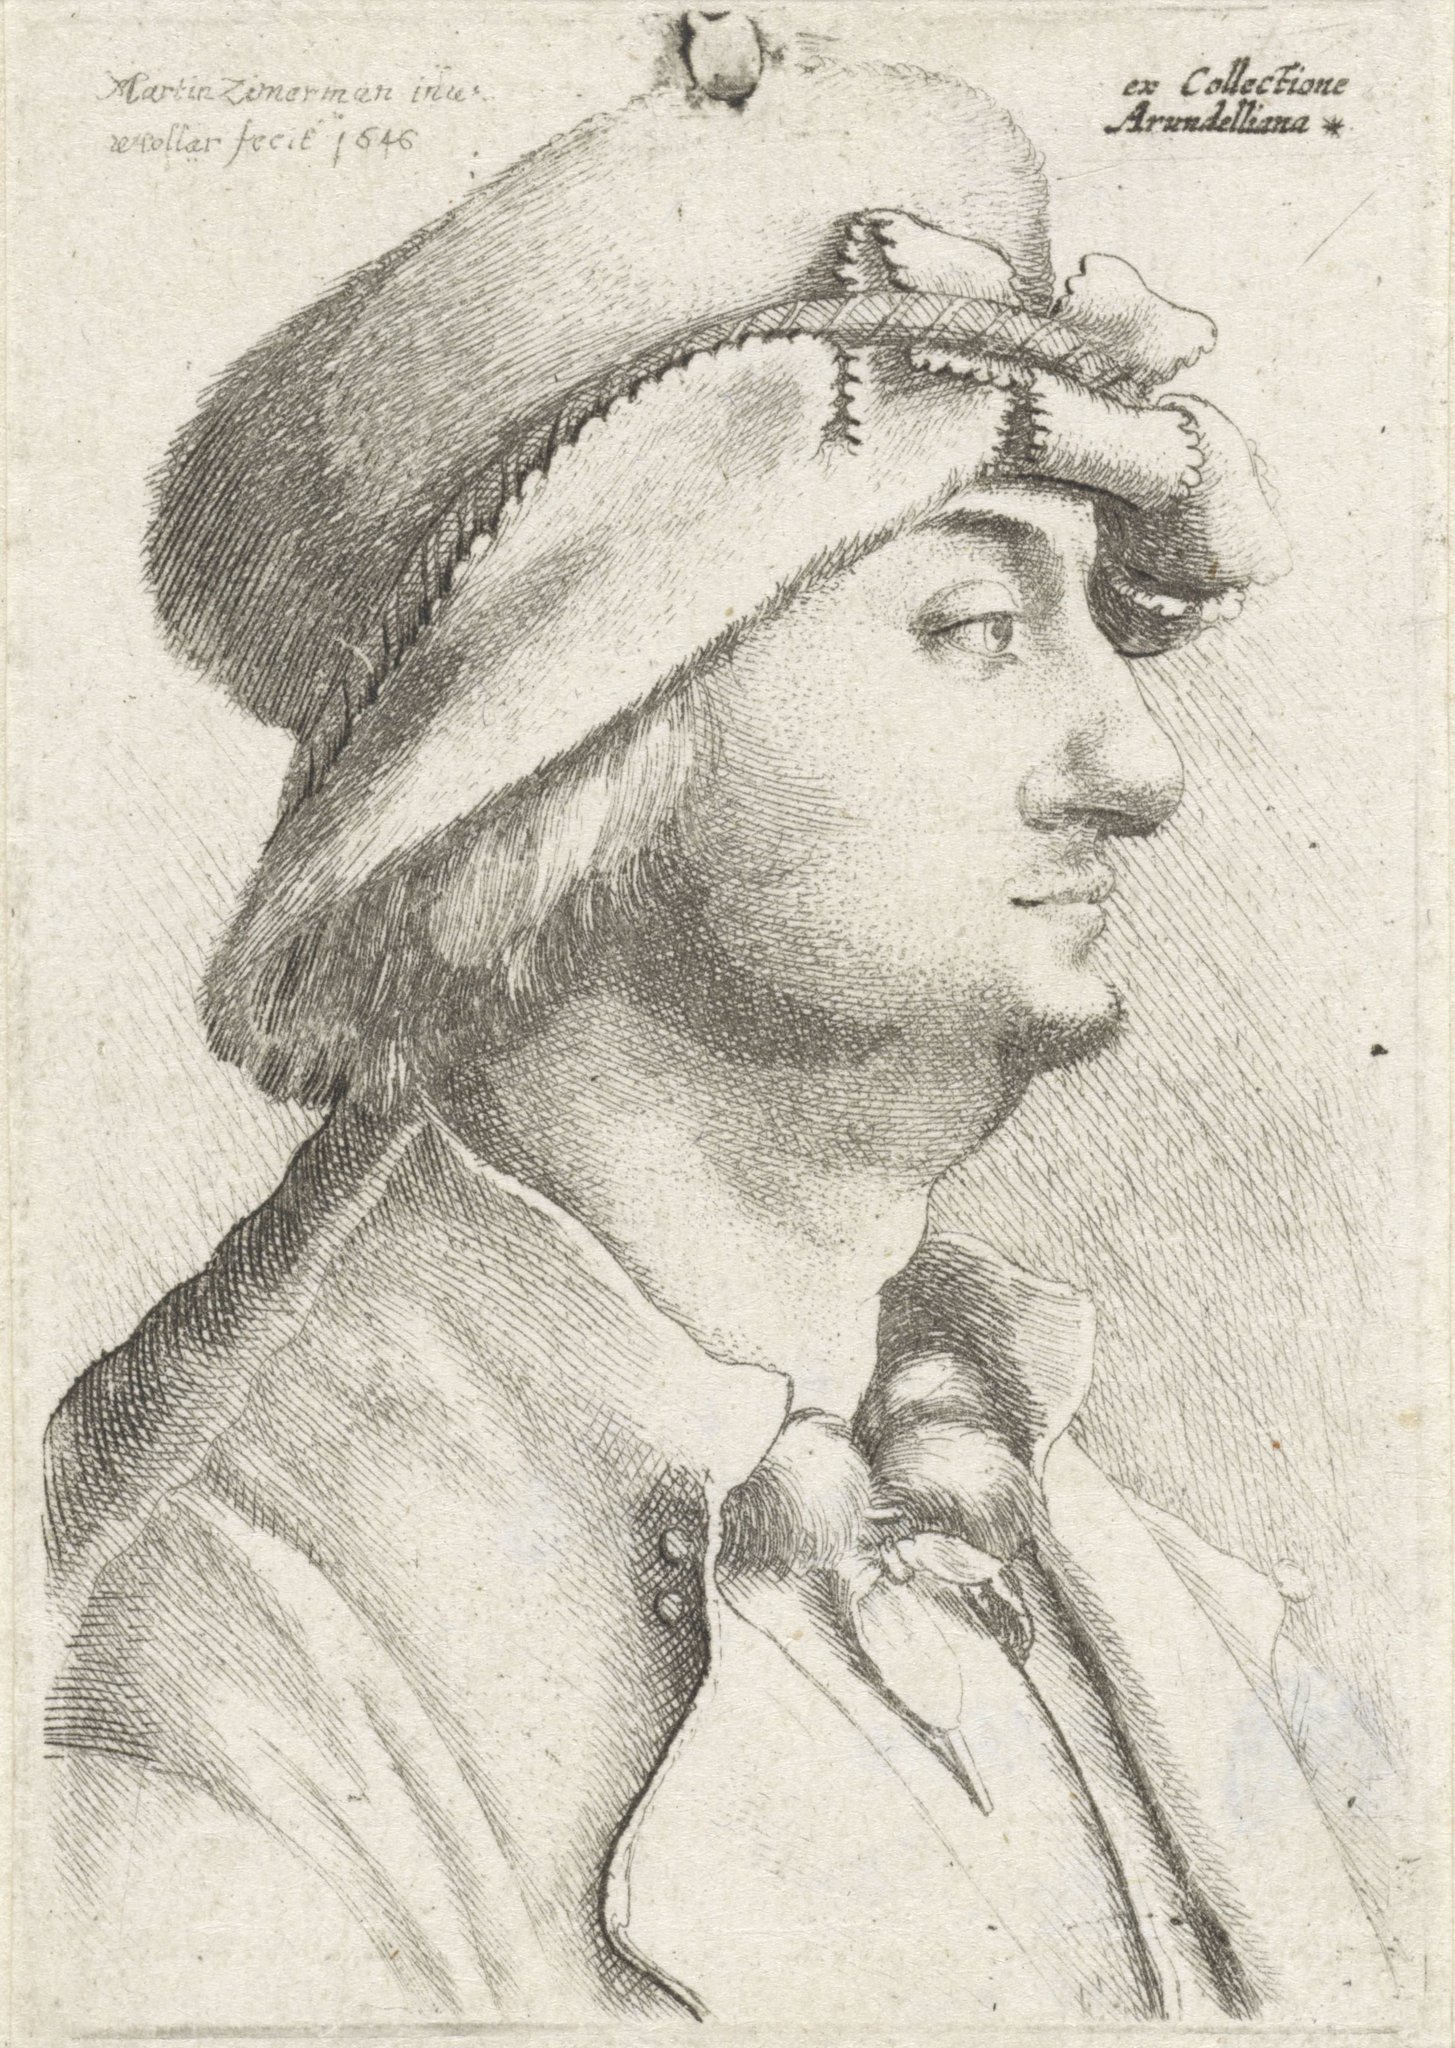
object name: print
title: Portret van een man met een vilten hoed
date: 1646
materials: paper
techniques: etching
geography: antwerp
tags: anonymous historical person portrayed alone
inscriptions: collector's mark: Lugt 567, collector's mark: Lugt 2233